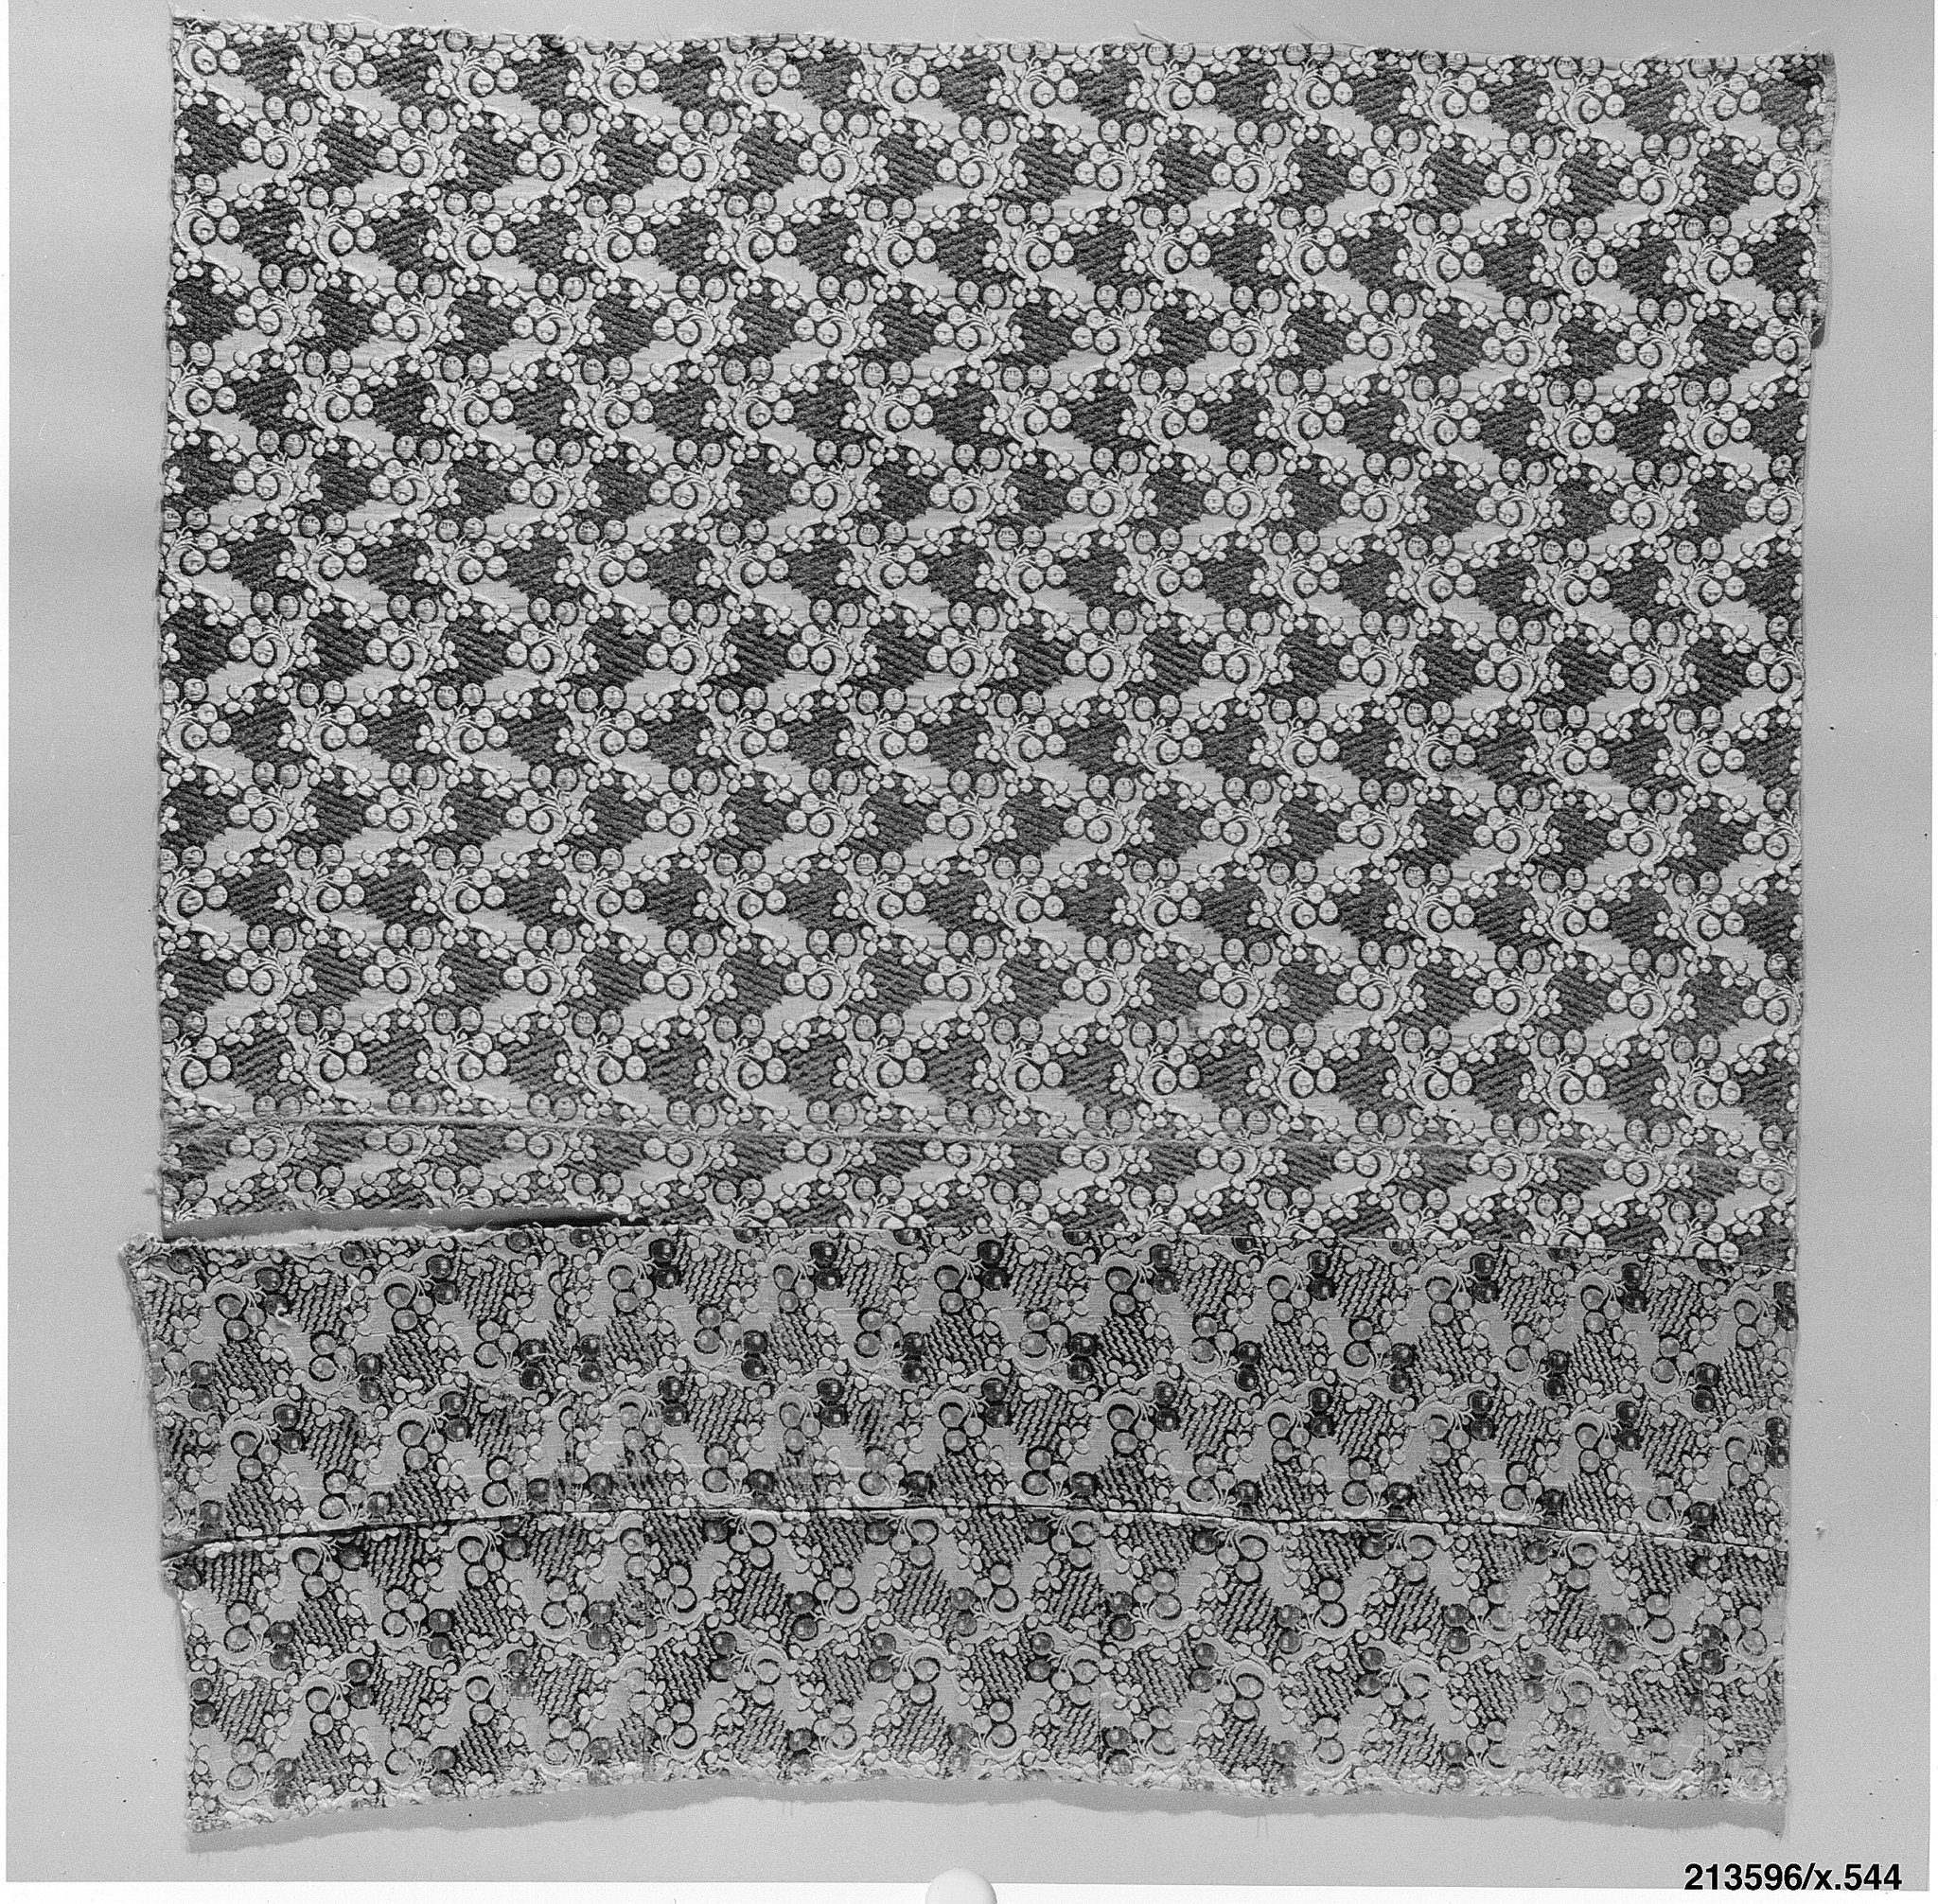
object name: piece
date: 1751-1800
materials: silk